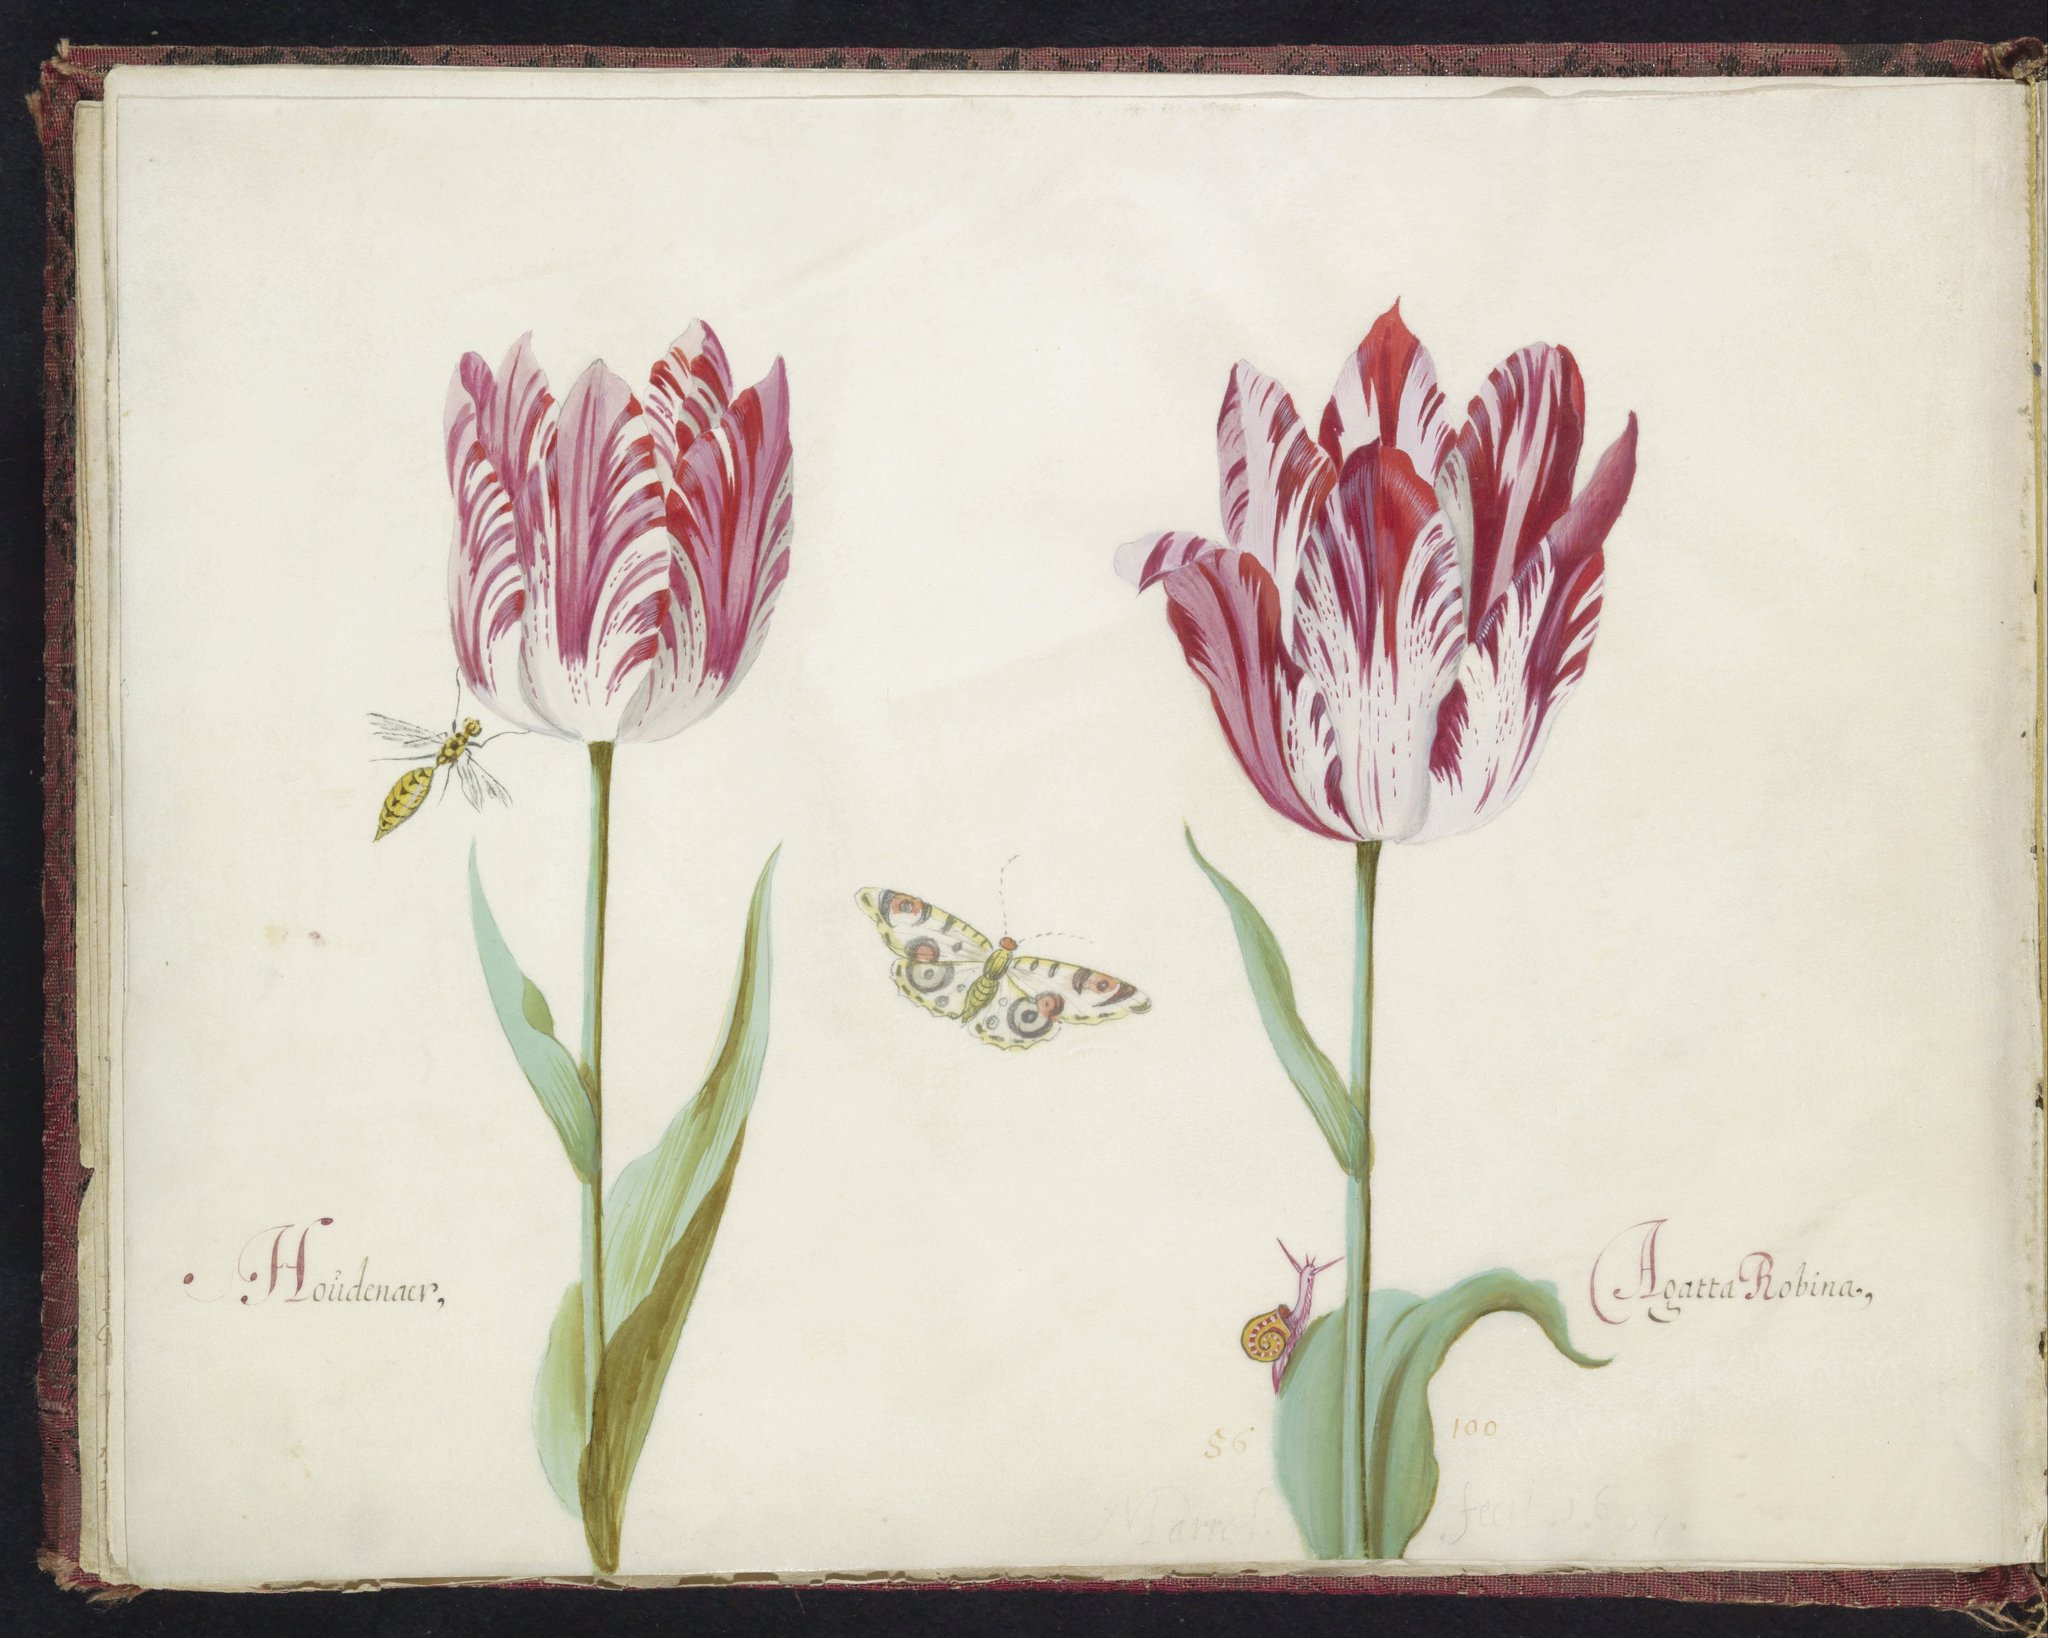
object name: drawing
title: Houdenaer / Agatta Robina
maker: jacob marrel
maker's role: draughtsman, painter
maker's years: 1614-1681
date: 1637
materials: paint, parchment, pencil, watercolor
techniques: brush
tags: insects: butterfly, flowers: tulip, molluscs: snail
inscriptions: date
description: De tekening maakt deel uit van een album.